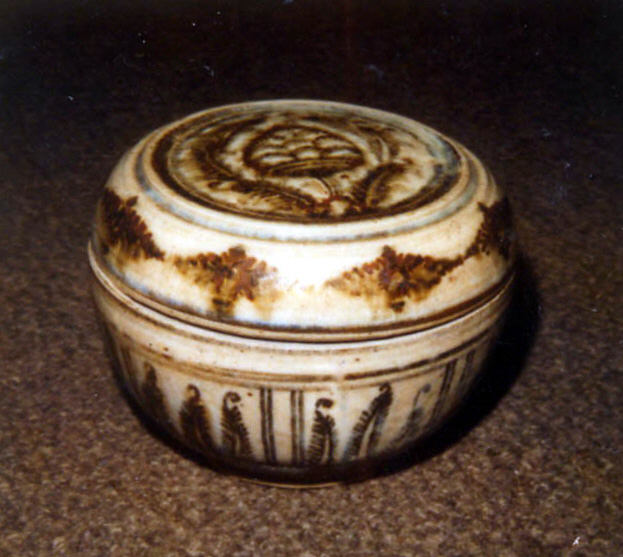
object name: covered box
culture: thai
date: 1401-1600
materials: earthenware, glaze, iron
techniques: underglaze